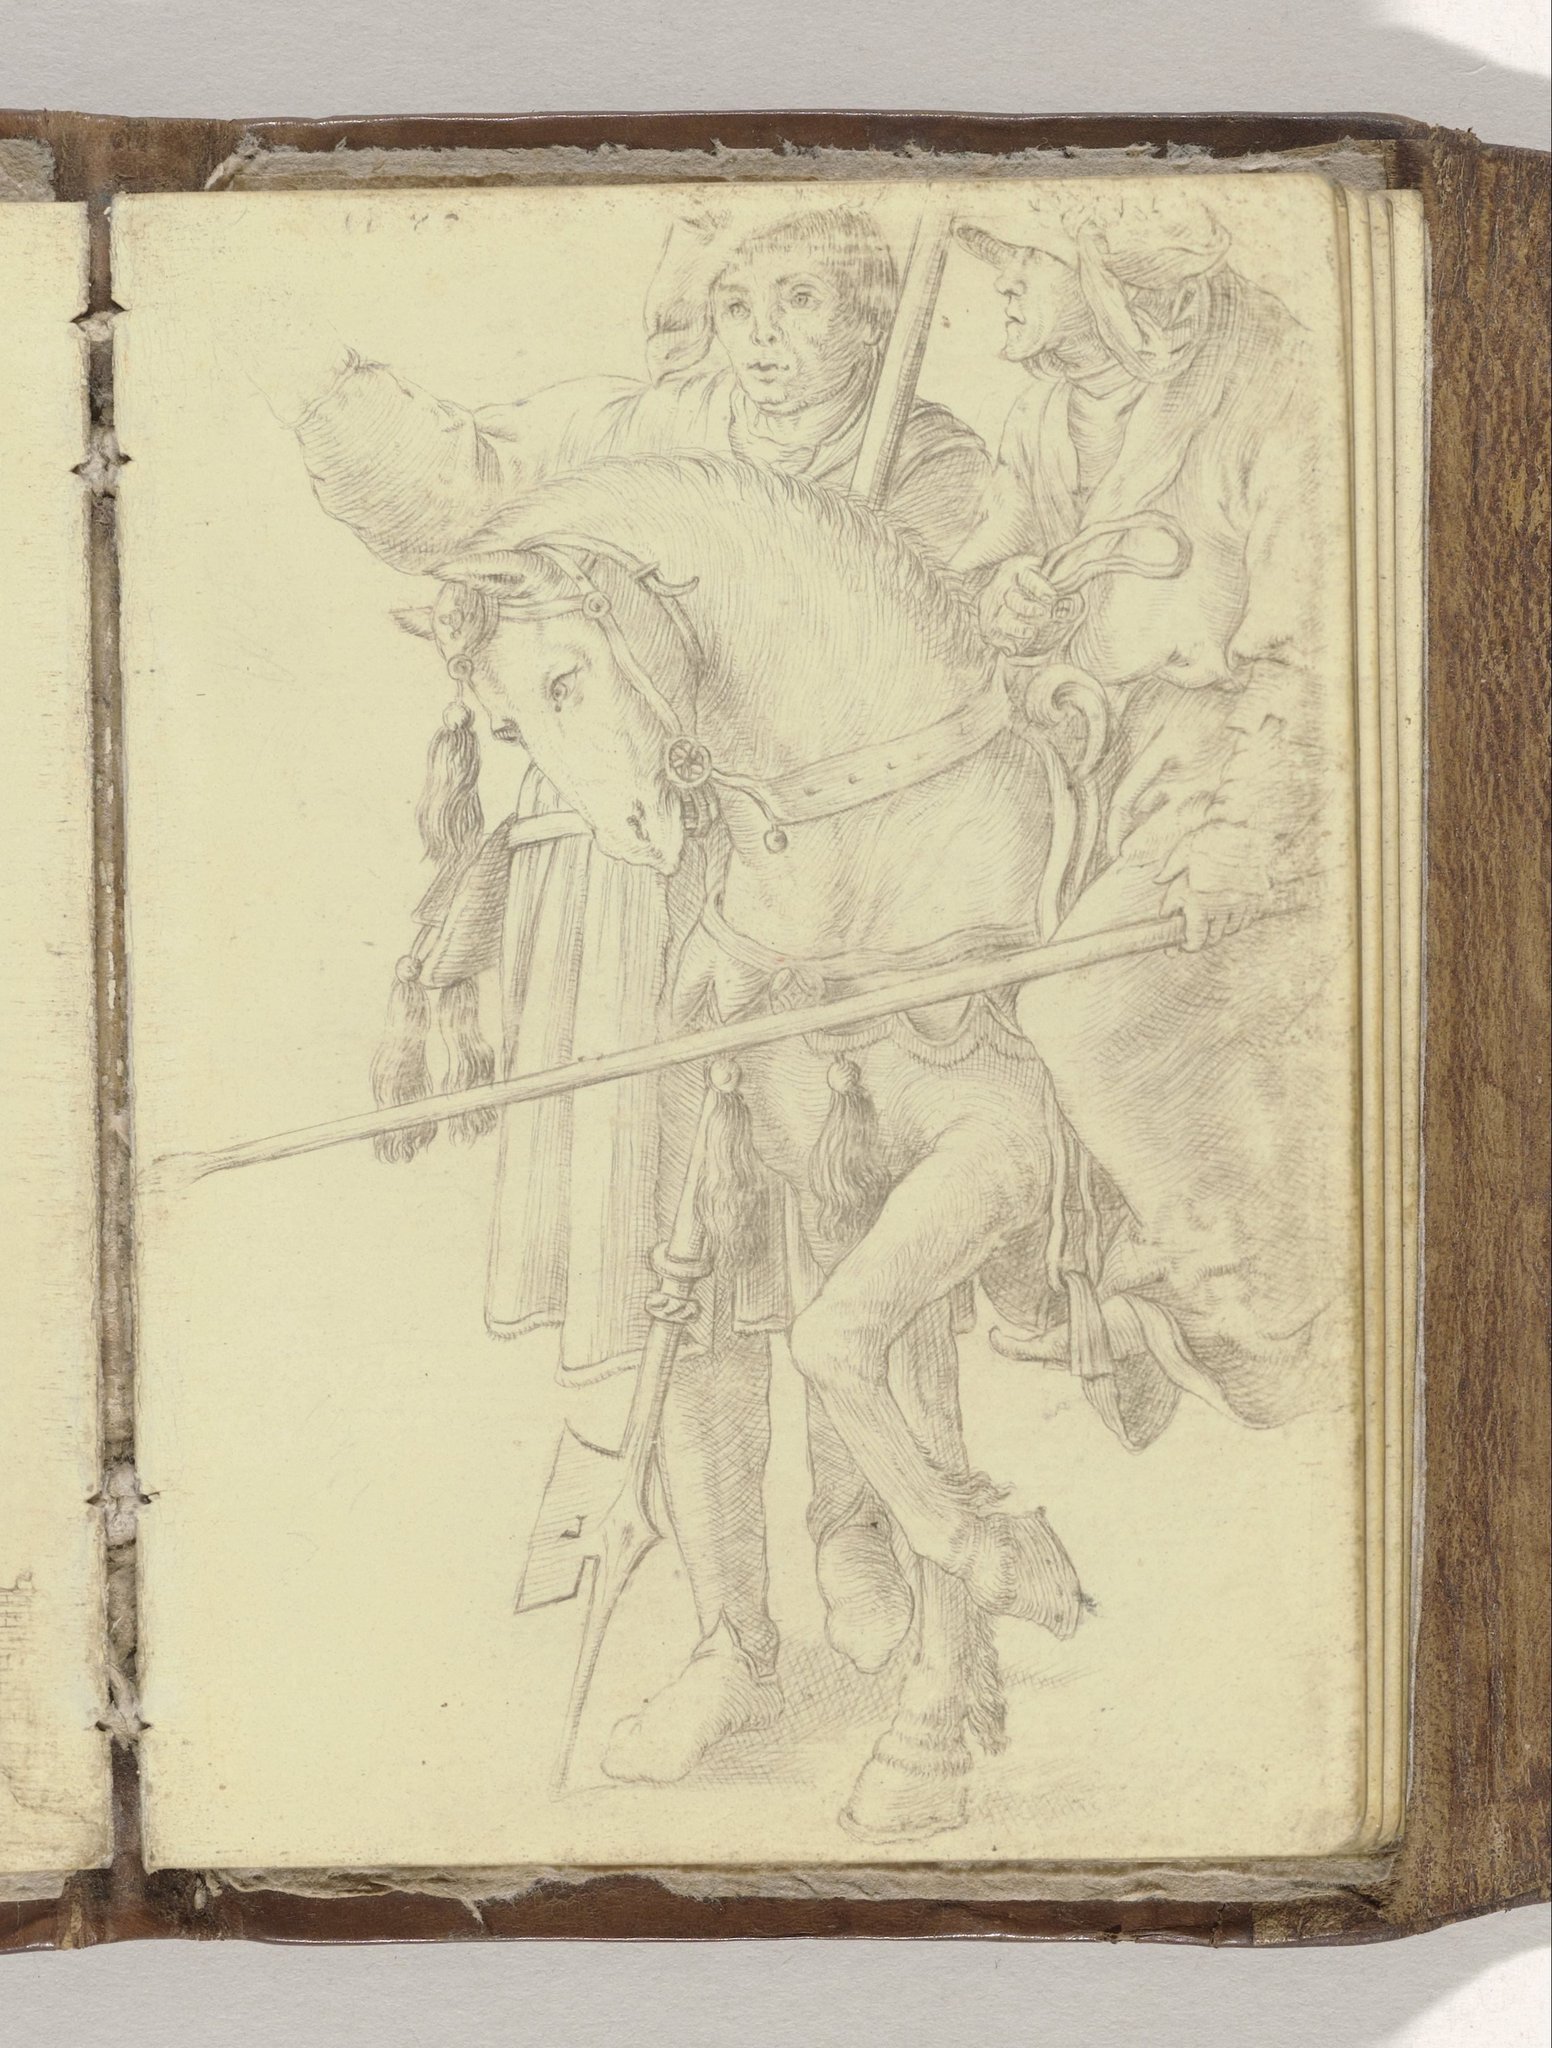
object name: metalpoint drawing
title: Schetsboek "A.S.Fe", 1587, blad 3r(12)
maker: Anonymous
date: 1585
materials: paper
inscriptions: date